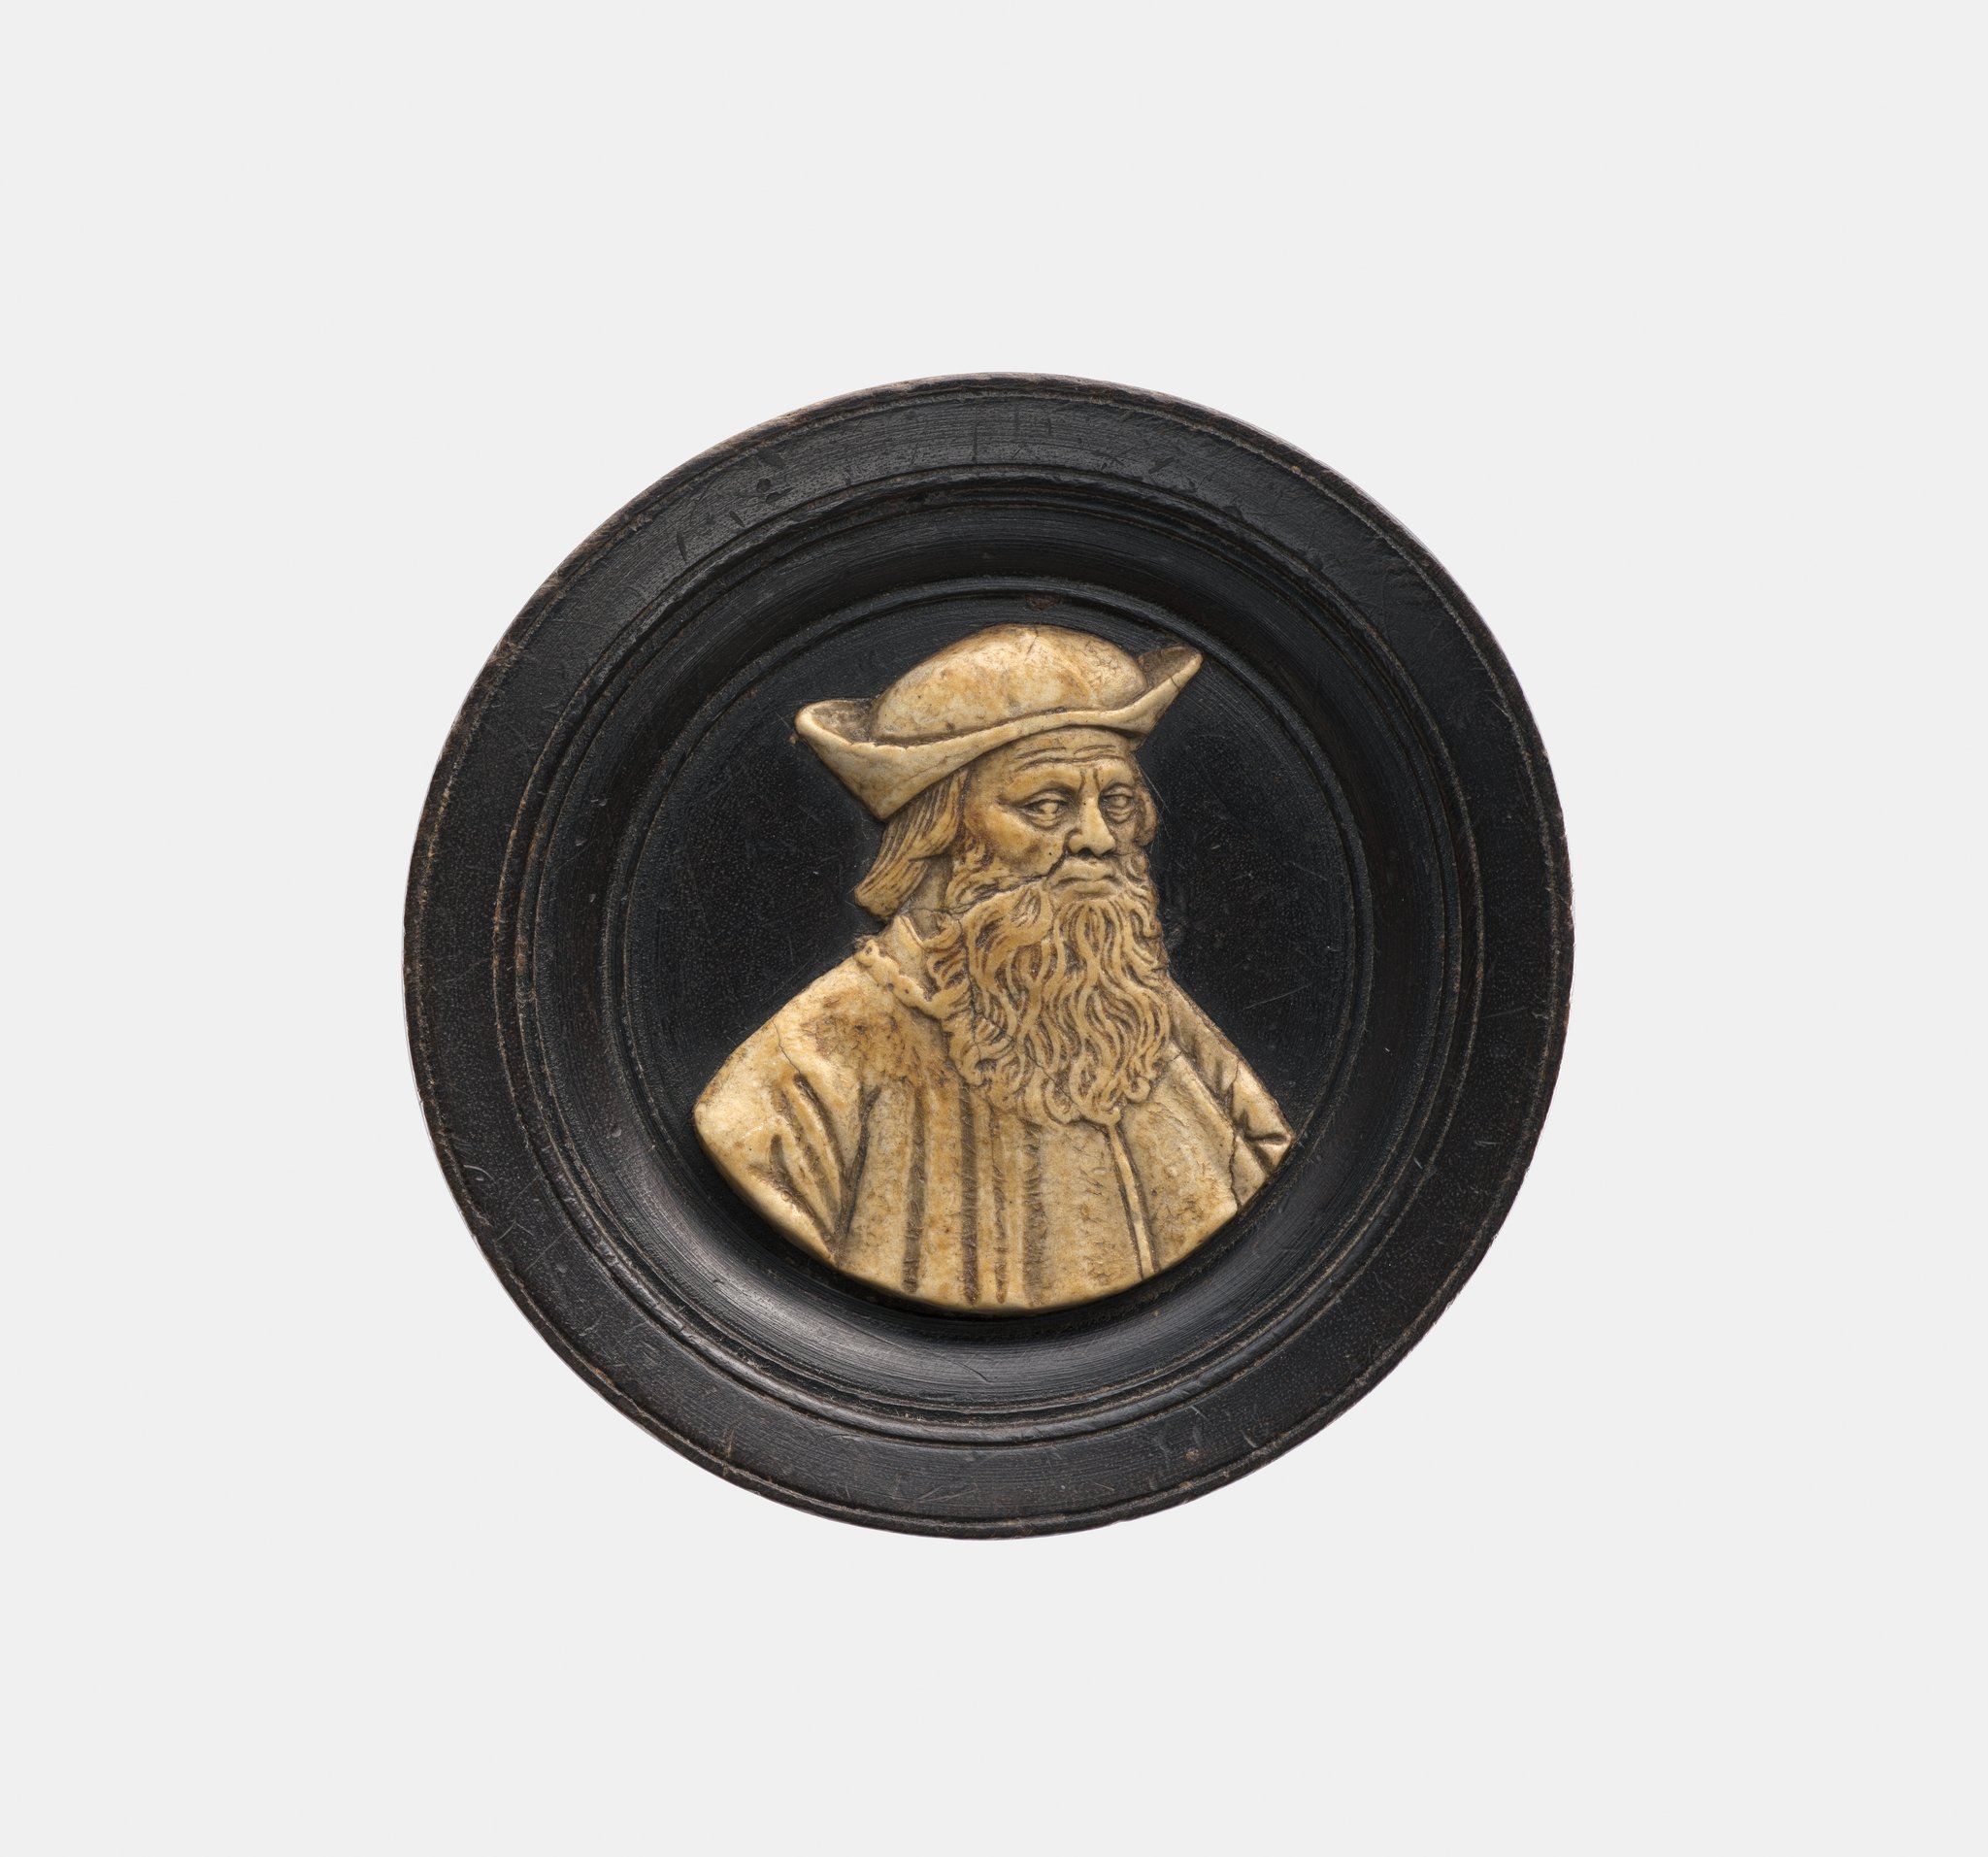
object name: checker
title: Portrait of a Humanist (possibly Johann Caesarius, Ph.D. and M.D., born Juelich 1468)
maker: Anonymous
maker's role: artist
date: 1530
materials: wood, marble